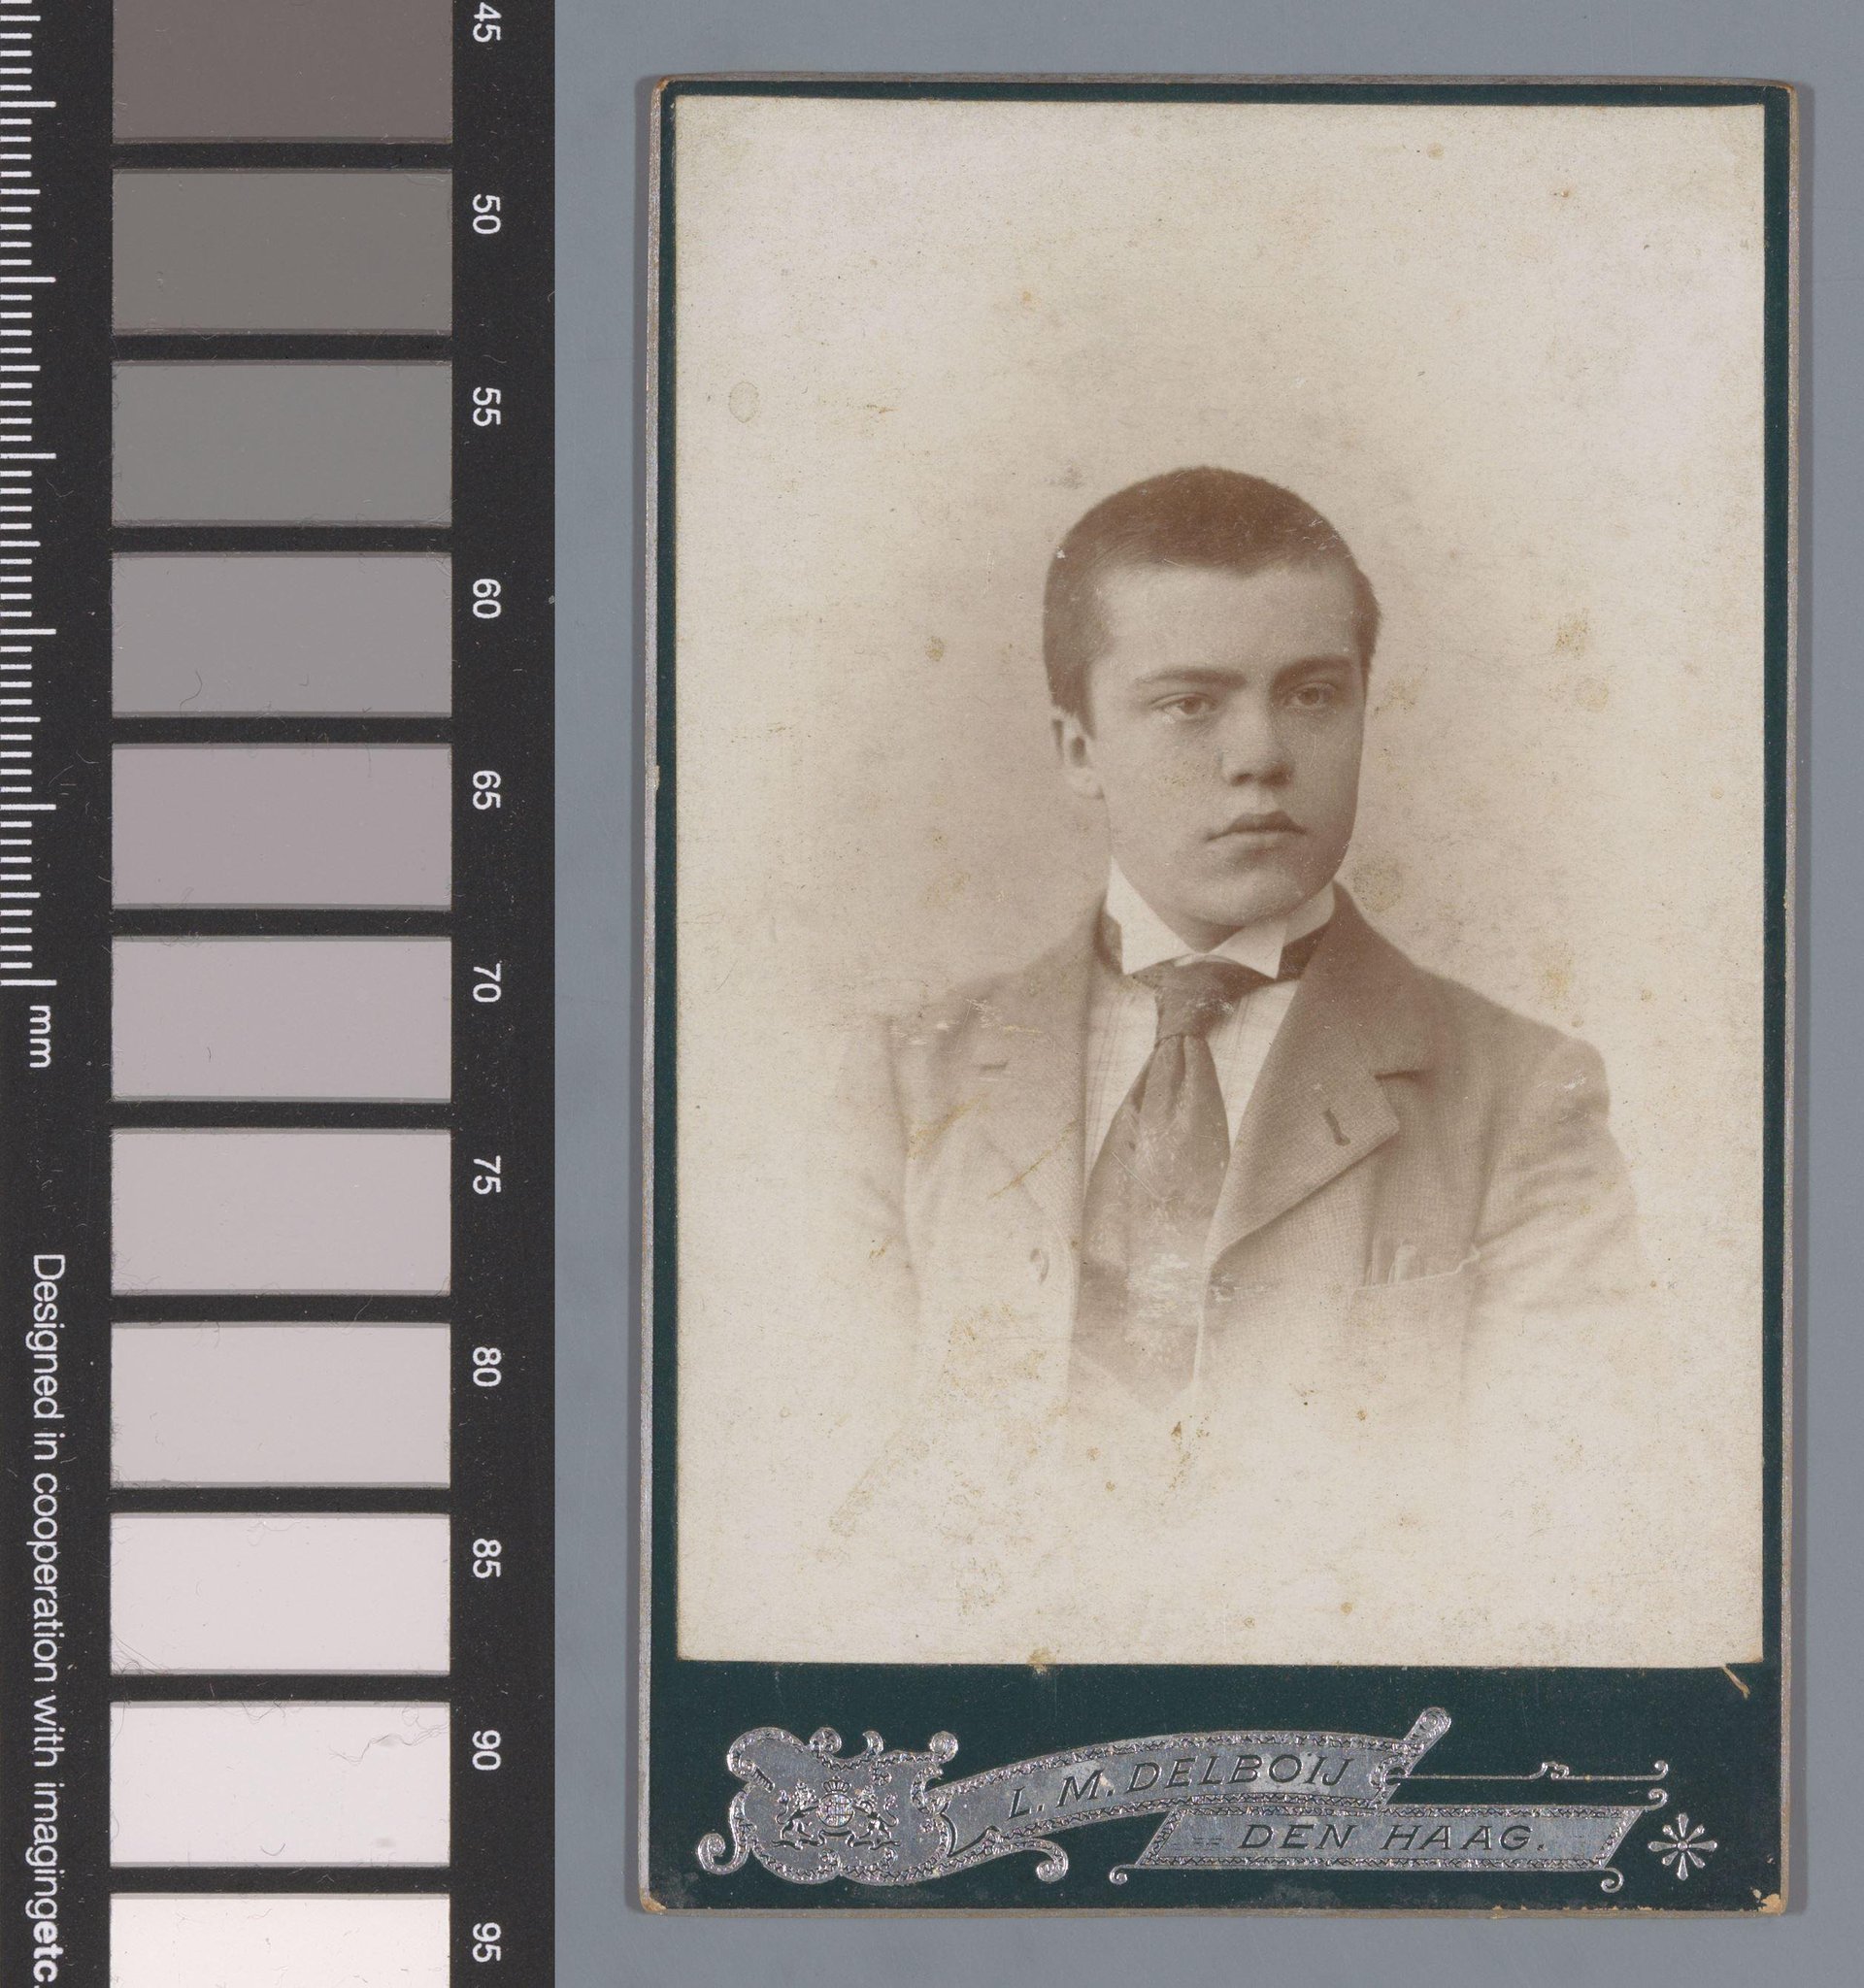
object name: photograph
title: Portret van een onbekende man of jongen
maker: lambertus martinus delboy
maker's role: fotograaf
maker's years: 1840-1891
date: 1870-1891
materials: cardboard, paper, photographic support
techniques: daylight paper print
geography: the hague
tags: youth, adolescent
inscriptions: name: ‘L.M. Delboij Hof Photograaf Den Haag 12 Gortstraat 12. De plaat blijft voor nabestelling bewaard.’, name: ‘L.M. Delboij Den Haag.’